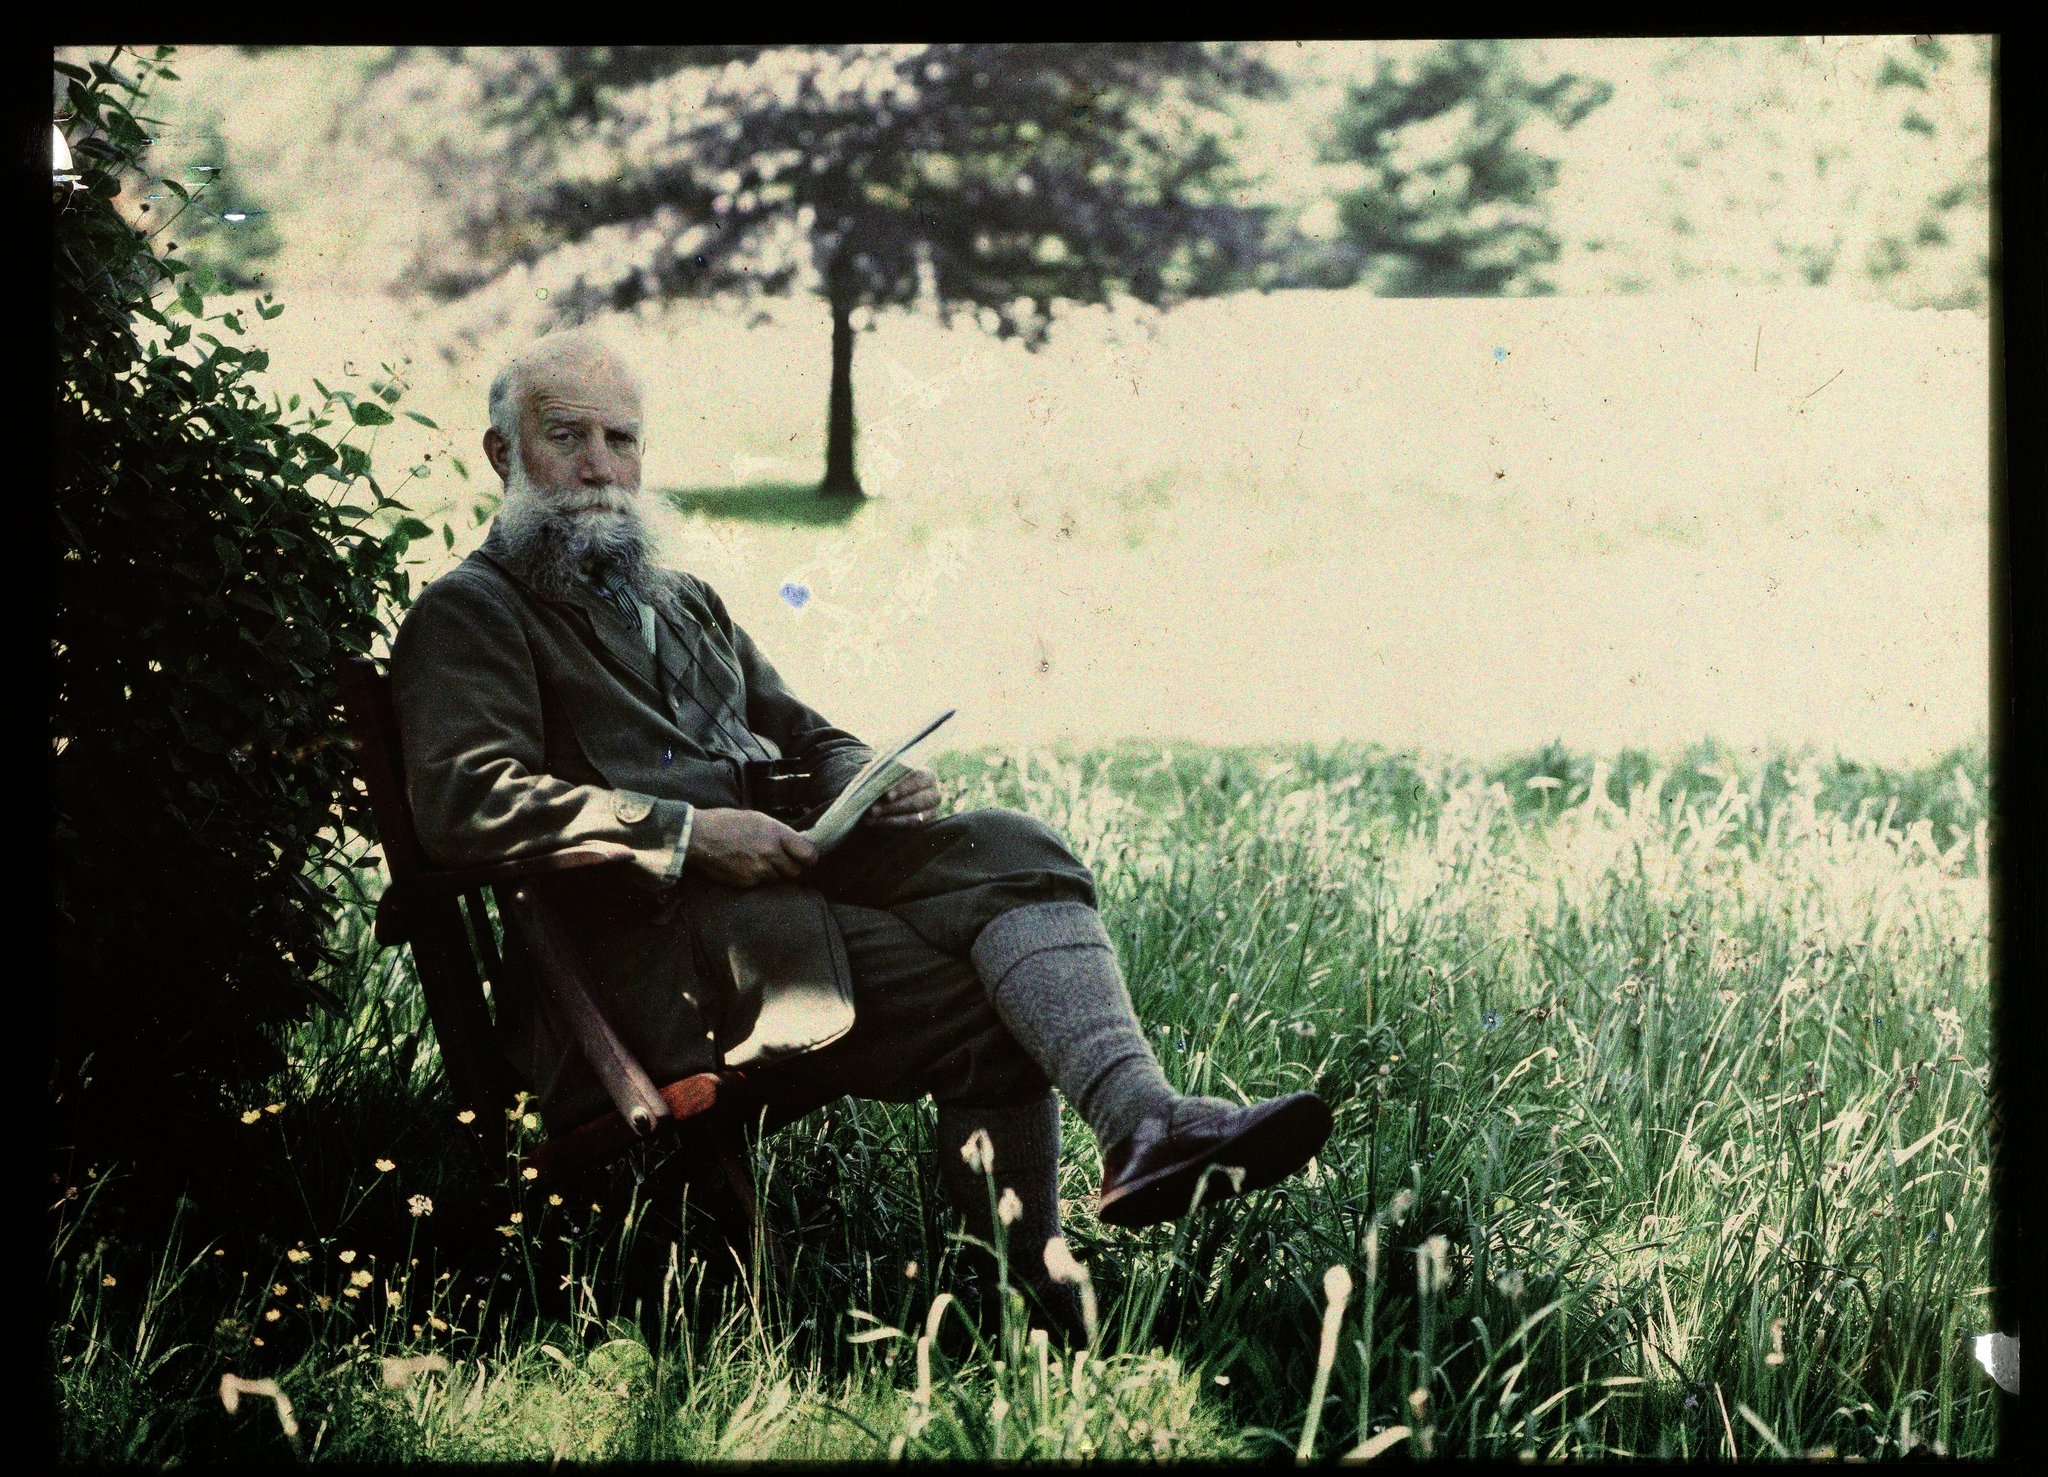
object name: glasdia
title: Oude man met baard zittend in een stoel in een grasveld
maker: adolphe burdet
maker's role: fotograaf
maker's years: 1860-1940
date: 1907-1930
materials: glass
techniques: autochrome process, slide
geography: netherlands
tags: adolphe burdet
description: Man met baard zittend in een stoel in een grasveld.